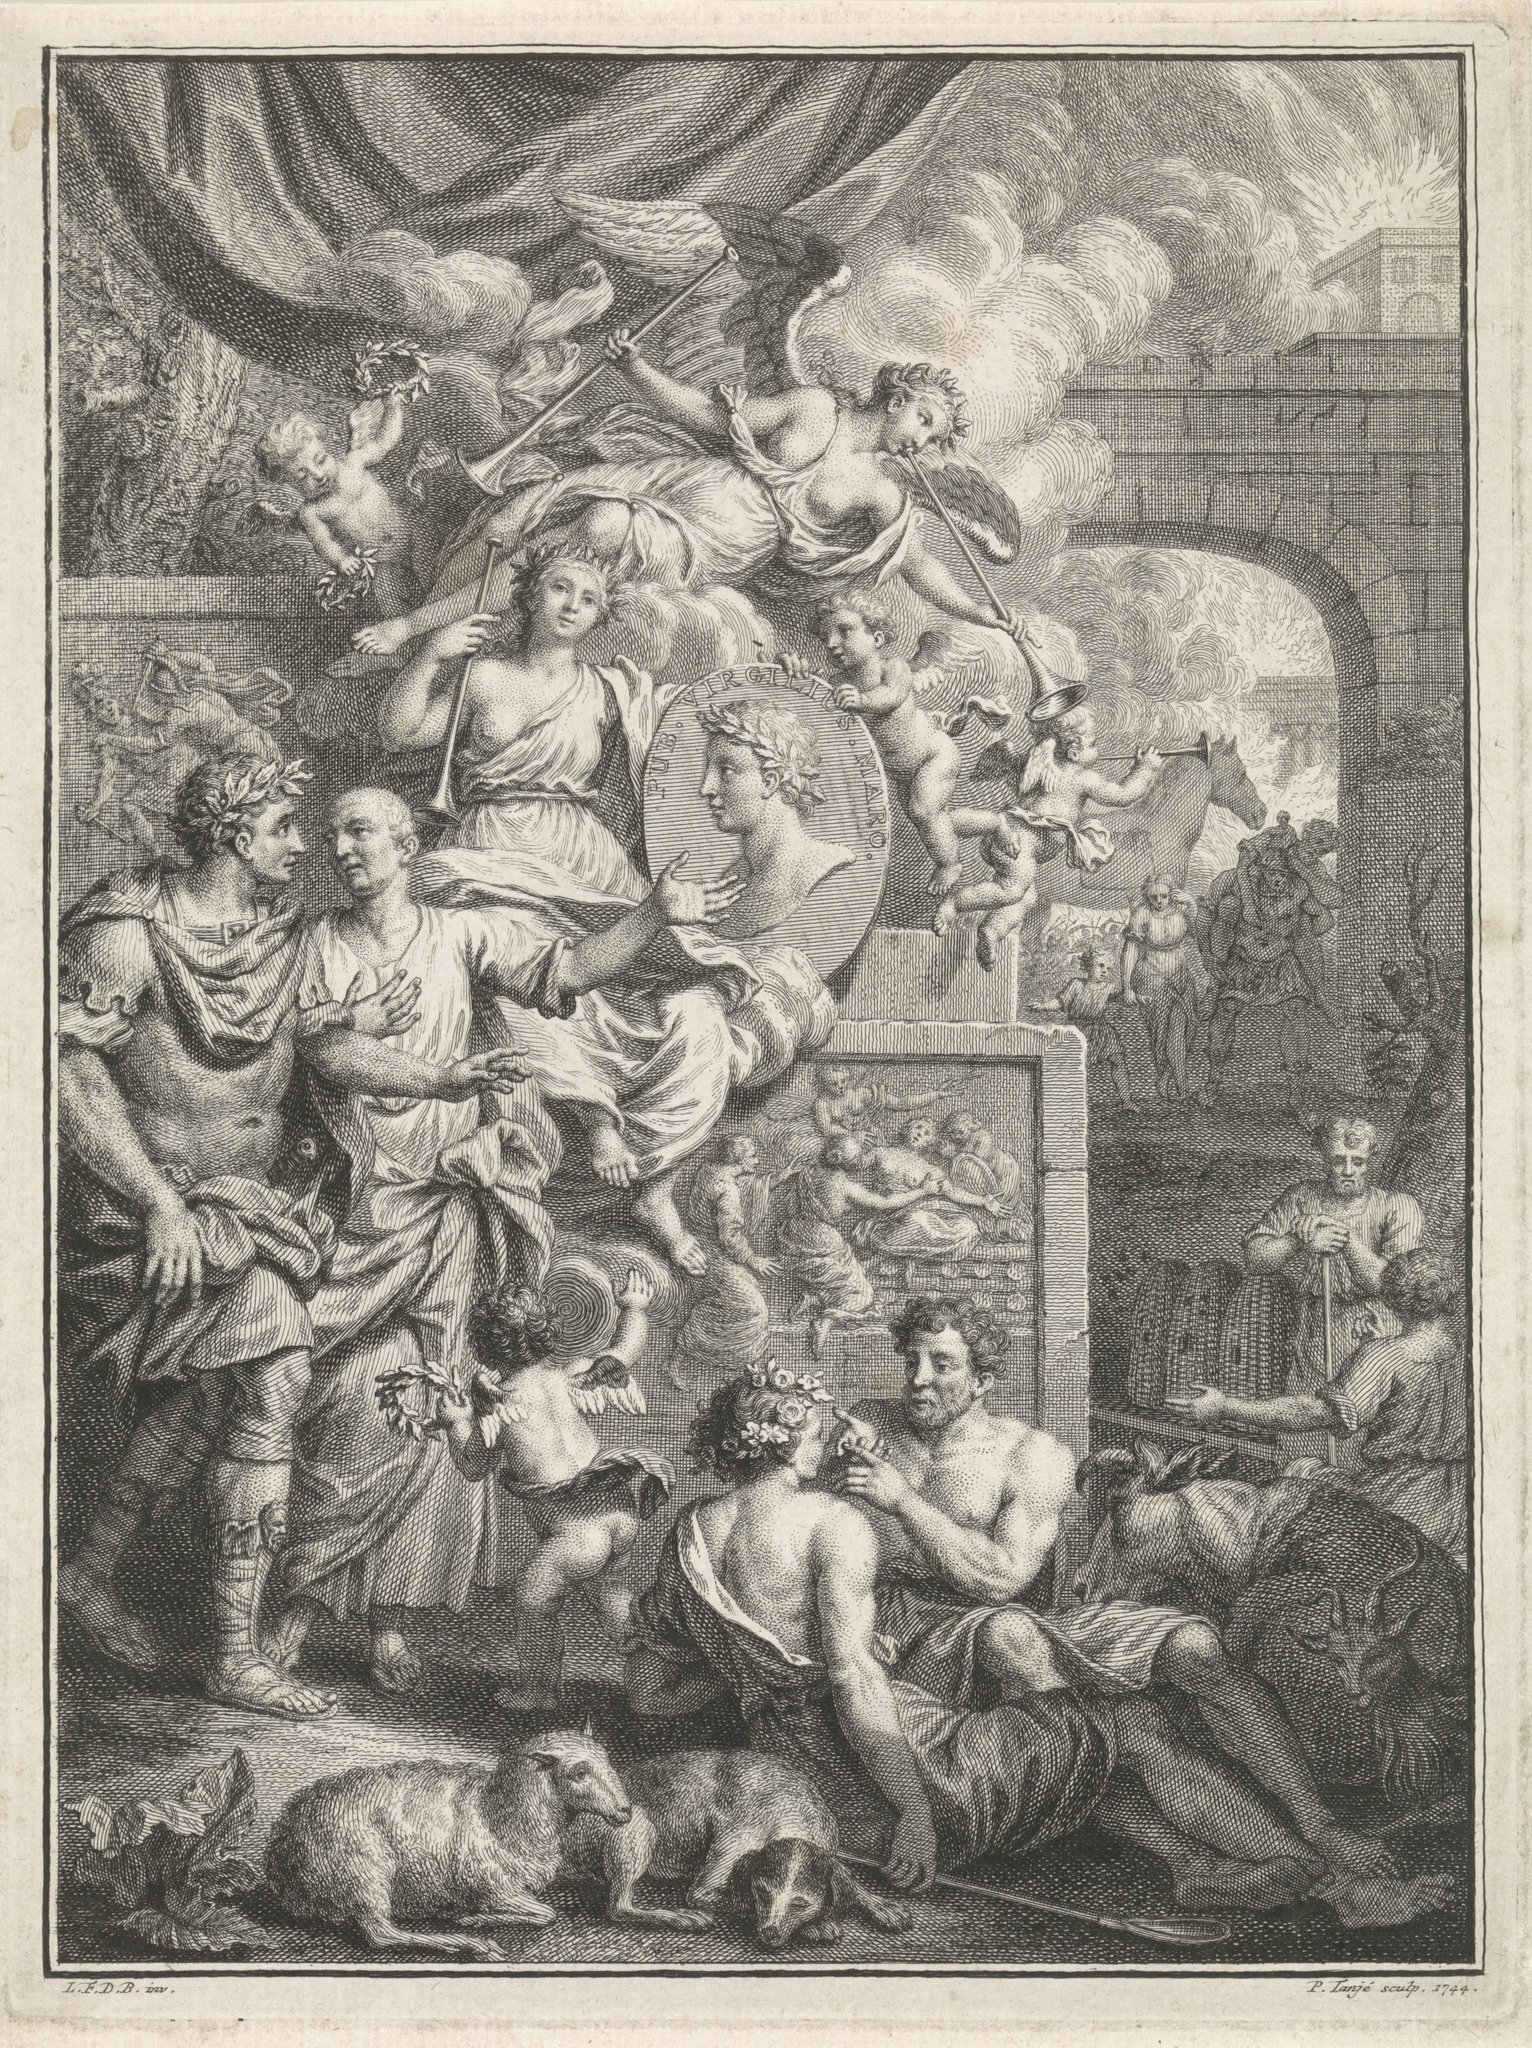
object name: titelblad, titelpagina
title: Faam met het portret van Publius Vergilius Maro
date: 1744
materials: paper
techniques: engraving, etching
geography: amsterdam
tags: publius vergilius maro, 'pius aeneas': aeneas, leading ascanius, escapes from burning troy, carrying his father anchises with the penates; his wife creusa, who sets out with them, is lost on the way, death of dido; she climbs the funeral pyre and falls upon the sword of aeneas, fame; 'fama', 'fama buona', 'fama chiara' (ripa)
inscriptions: collector's mark: Lugt 2228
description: Faam toont een reliëf met het portret van de schrijver Publius Vergilius Maro. Victoria blaast de trompet. Rond het monument voor de schrijver zijn verschillende scènes uit zijn boek de Aeneis te zien. Op het monument een reliëf met de dood van Dido. Rechts op de achtergrond het brandende Troje met het Trojaanse paard en Aeneas, die met zijn vader op zijn rug de stad ontvlucht.